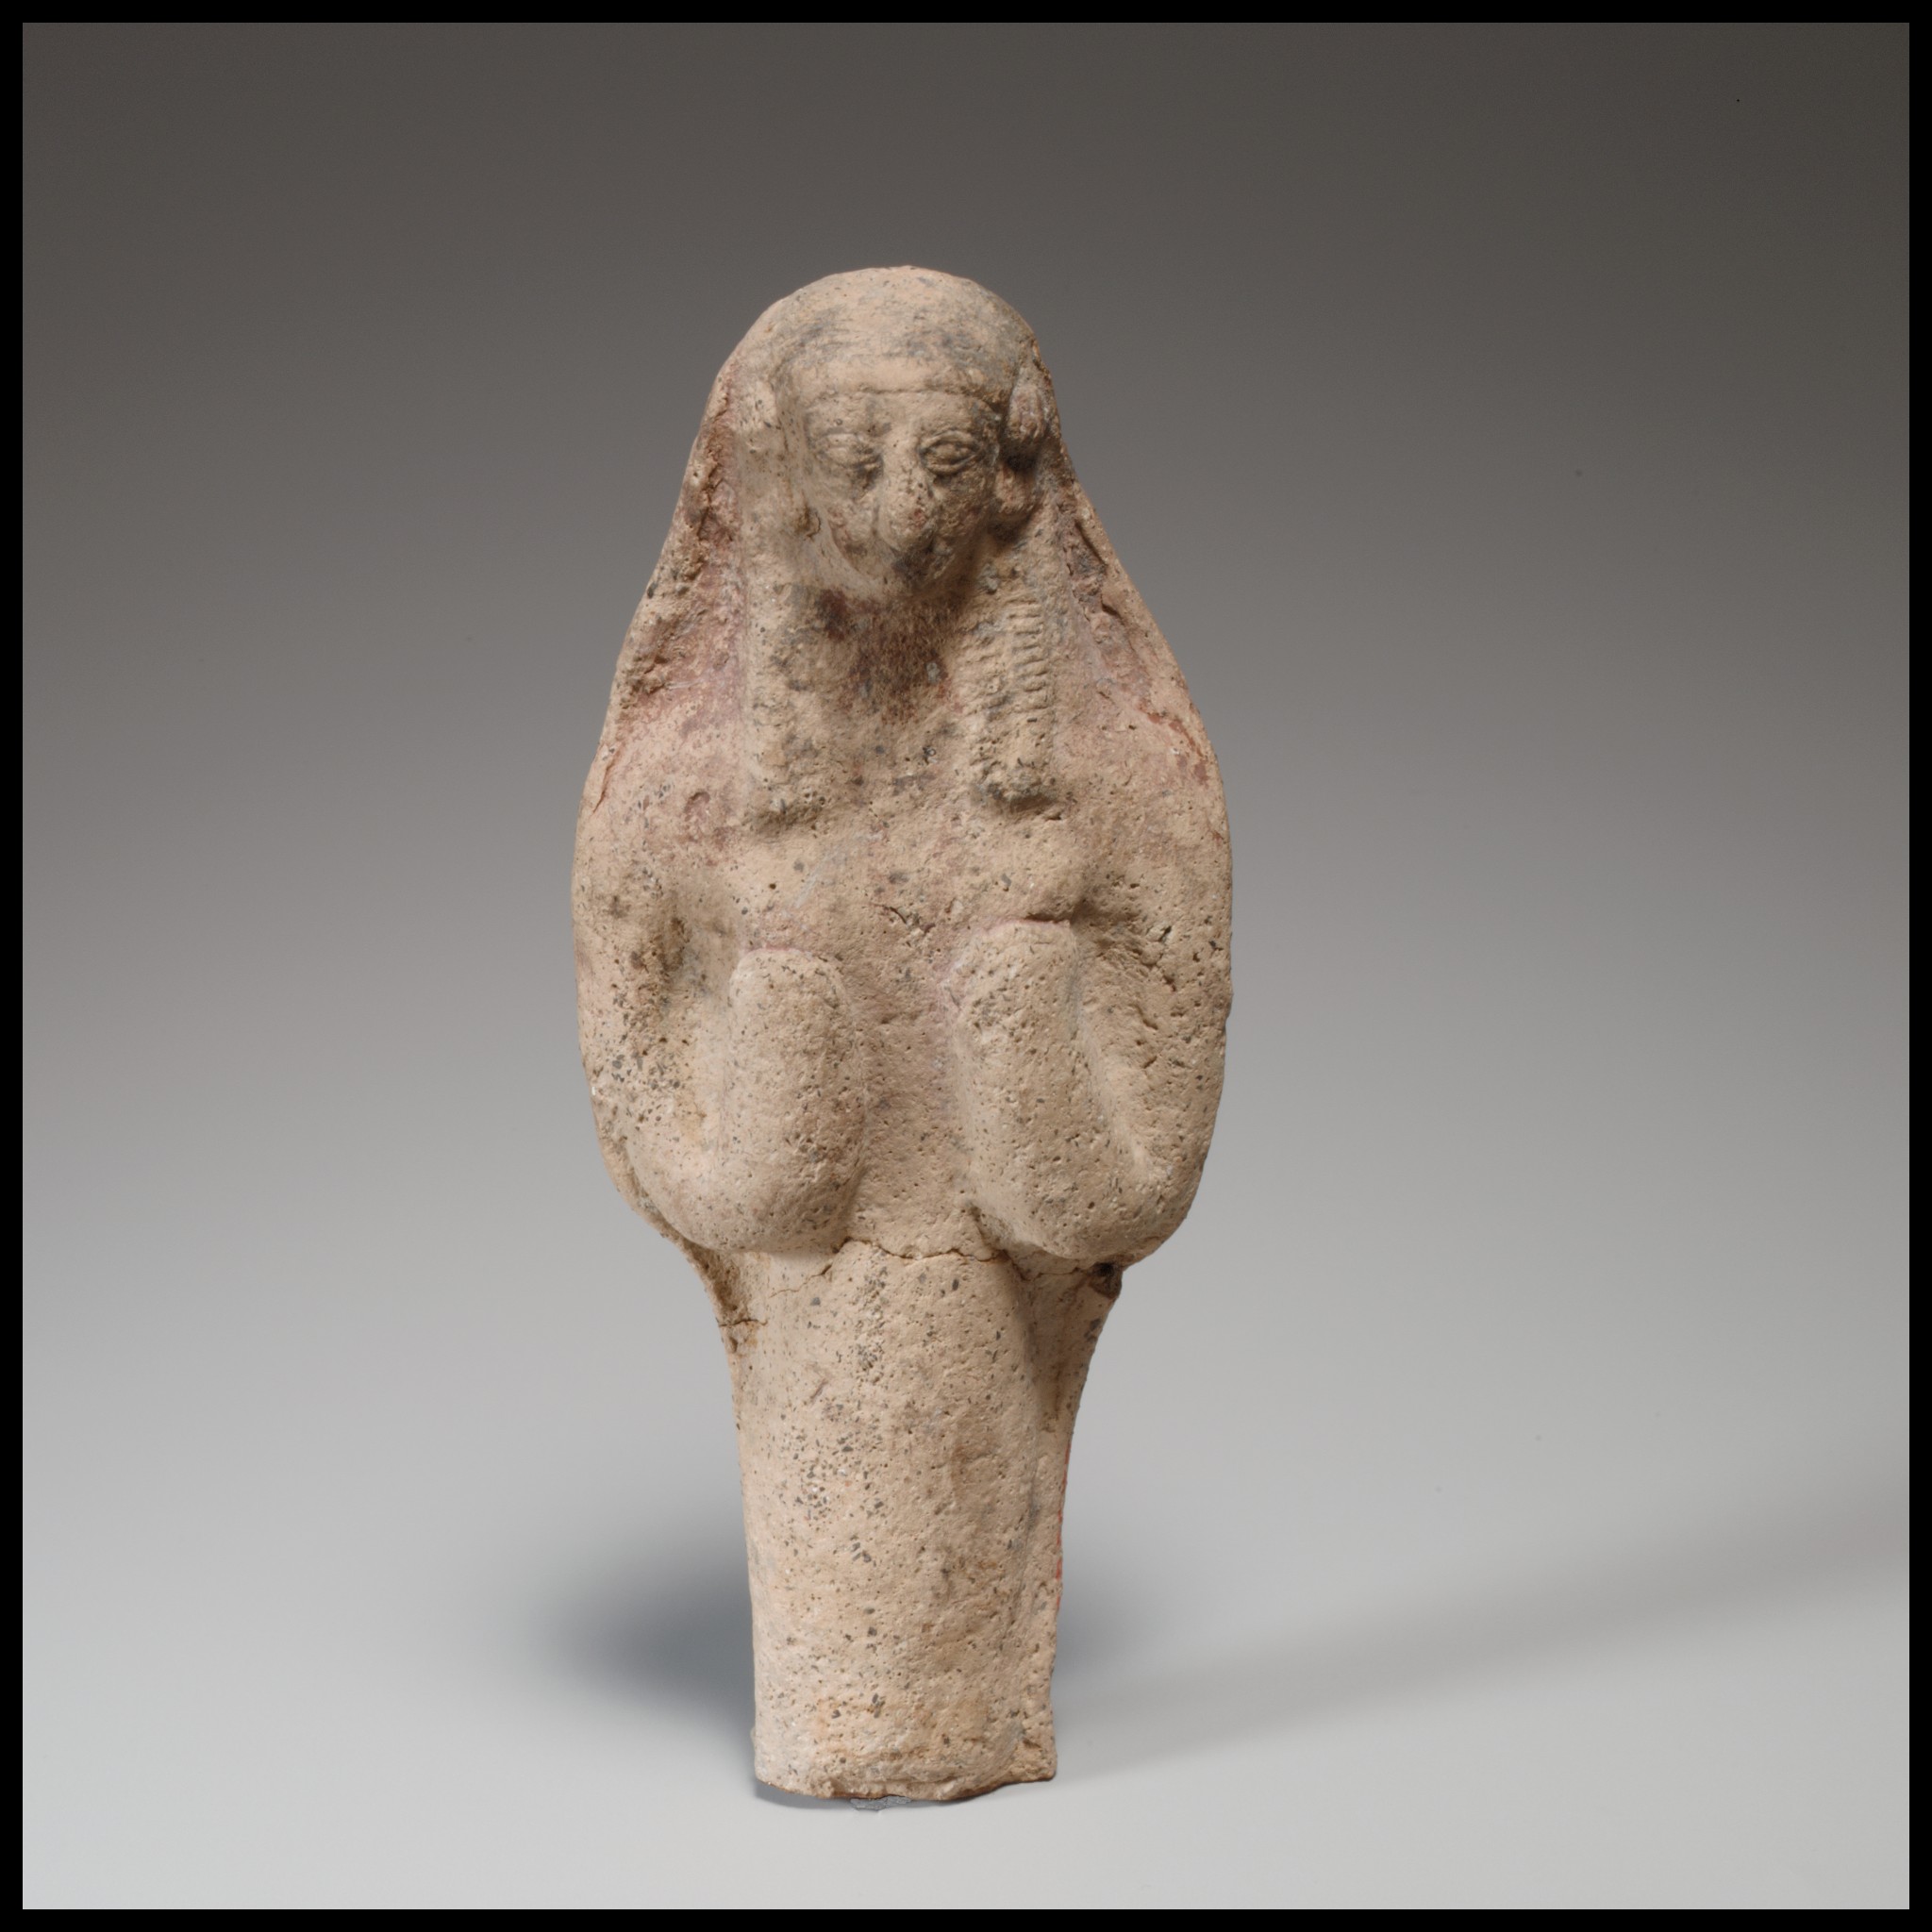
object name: statuette of a woman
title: Standing female figurine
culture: cypriot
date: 600-480 BCE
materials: terracotta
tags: women